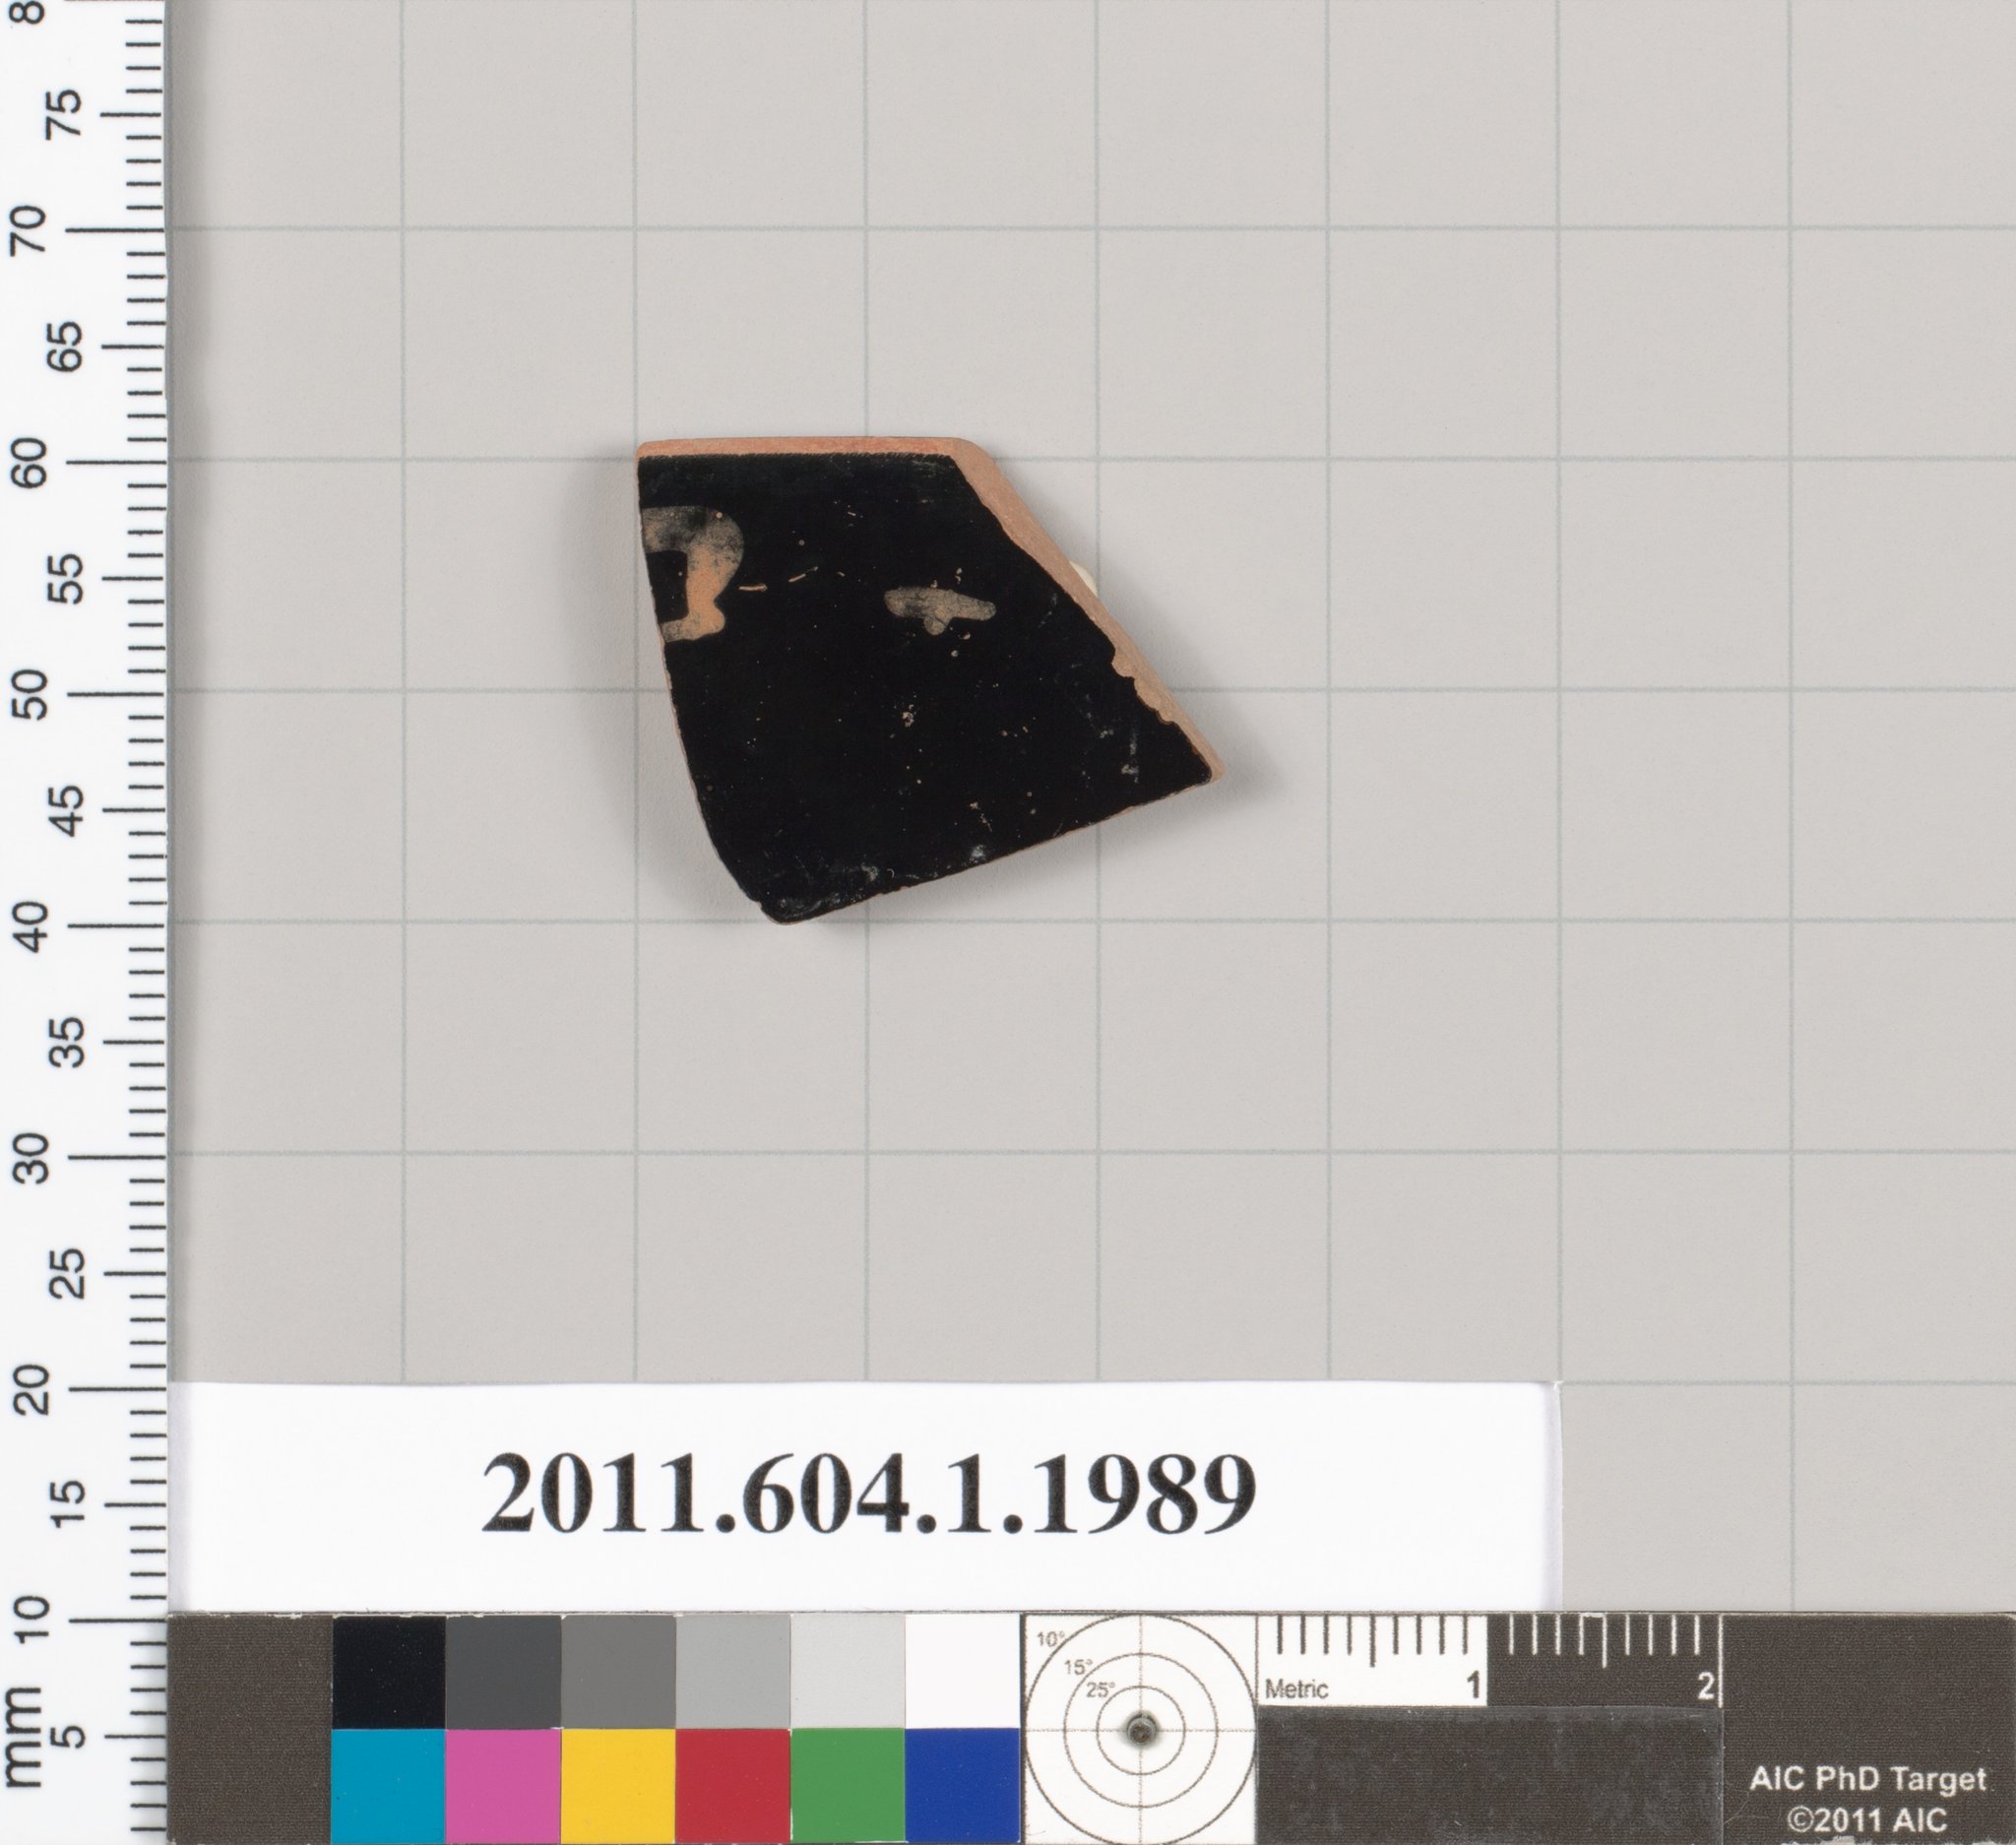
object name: kylix fragment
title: Terracotta rim fragment of a kylix (drinking cup)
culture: greek, attic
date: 500-401 BCE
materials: terracotta